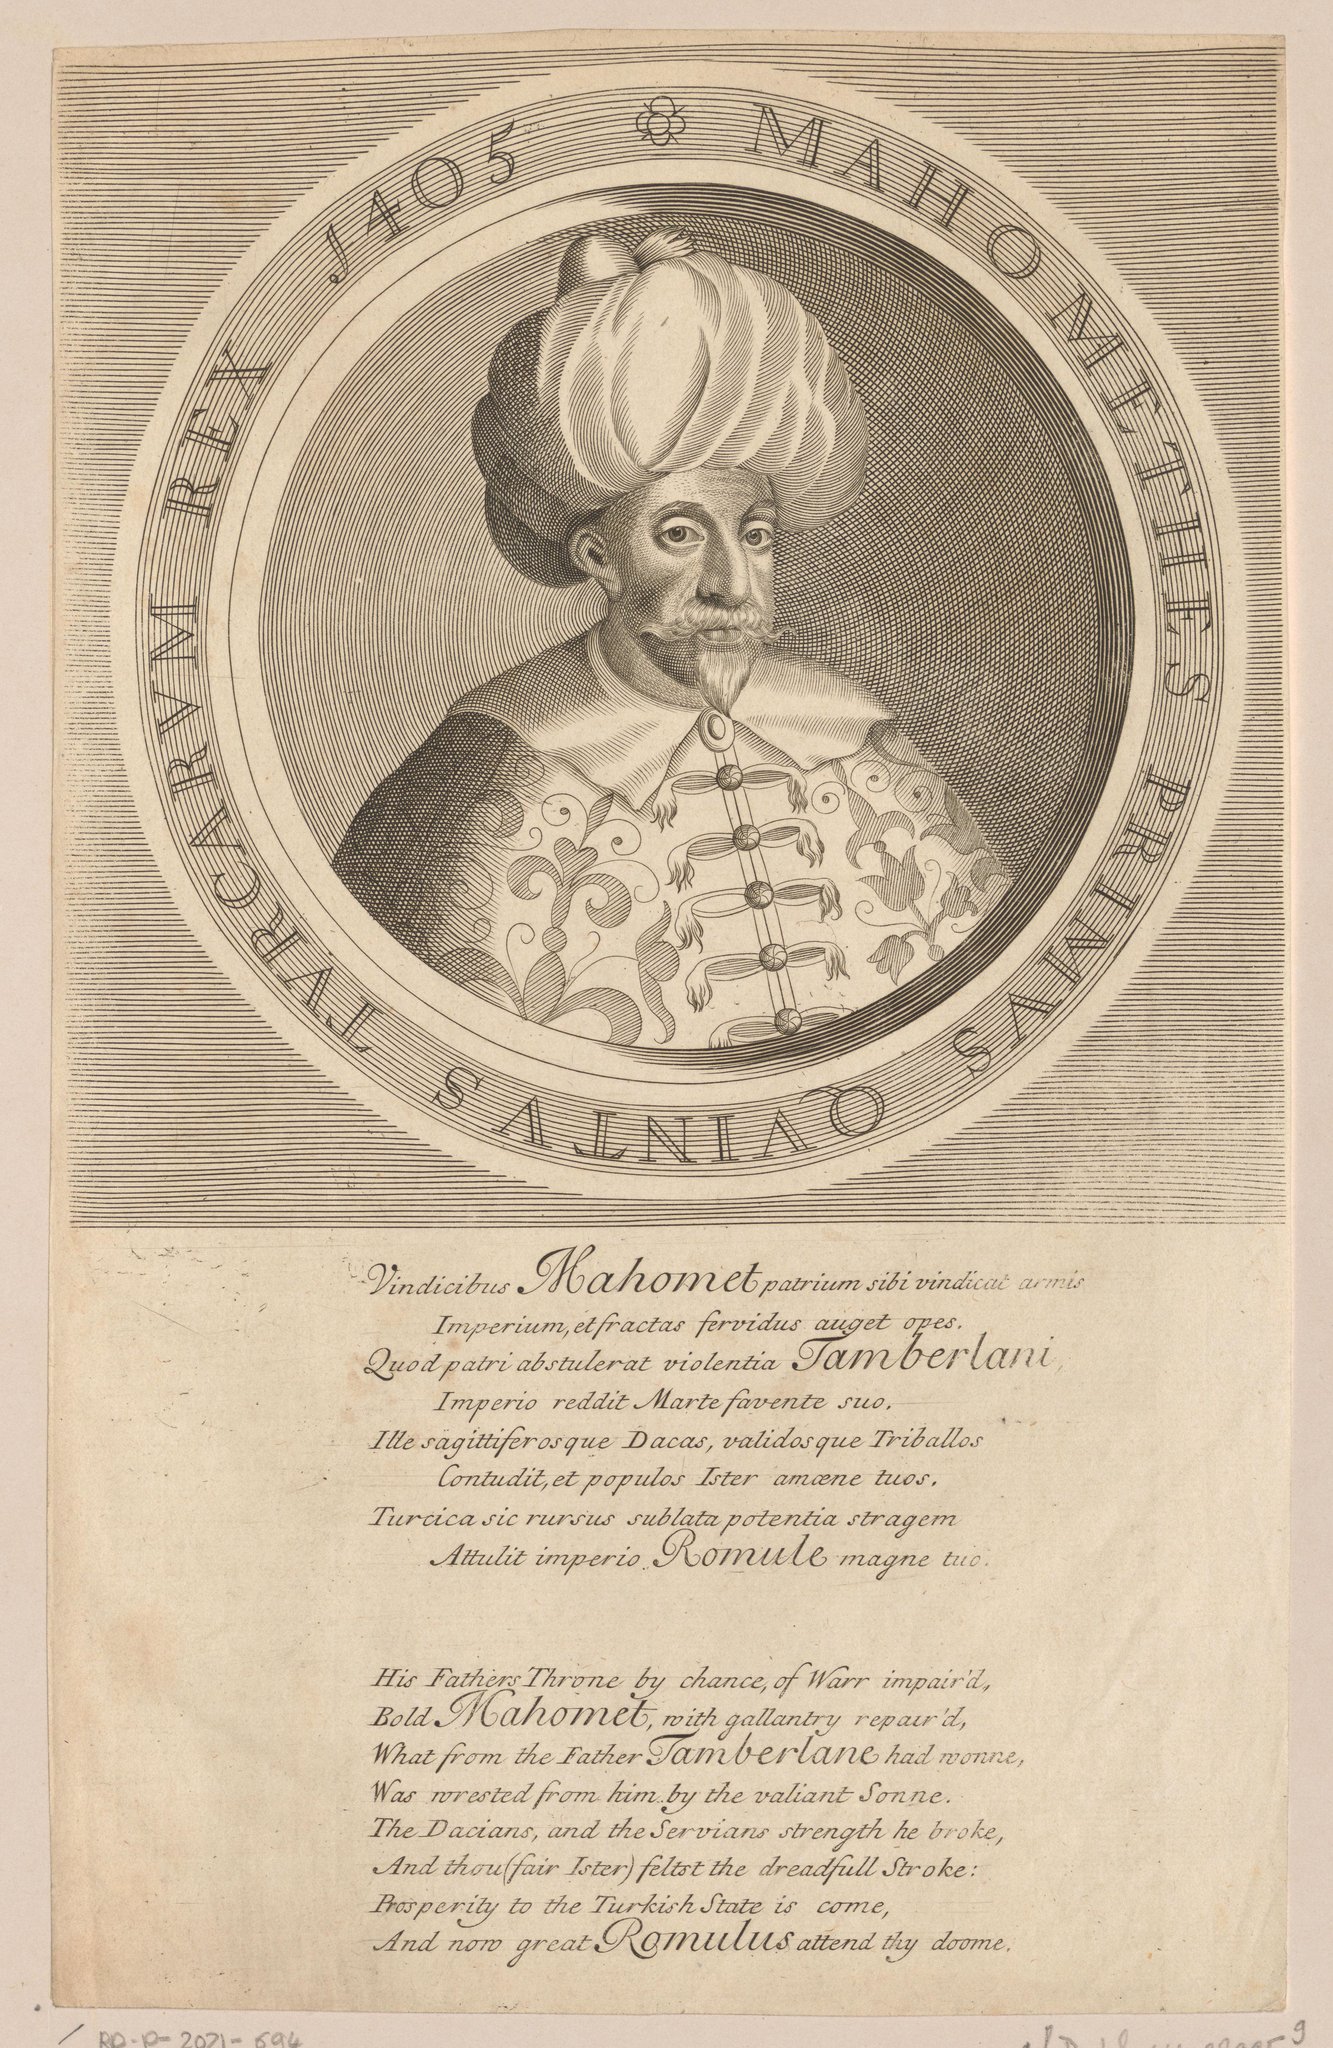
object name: print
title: Portret van Mehmet I, sultan van het Ottomaanse Rijk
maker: Anonymous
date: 1650-1750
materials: paper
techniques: engraving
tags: politician, historical persons, head-gear: turban, ruler, sovereign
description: Tekst in het Engels en in het Latijn in de ondermarge.